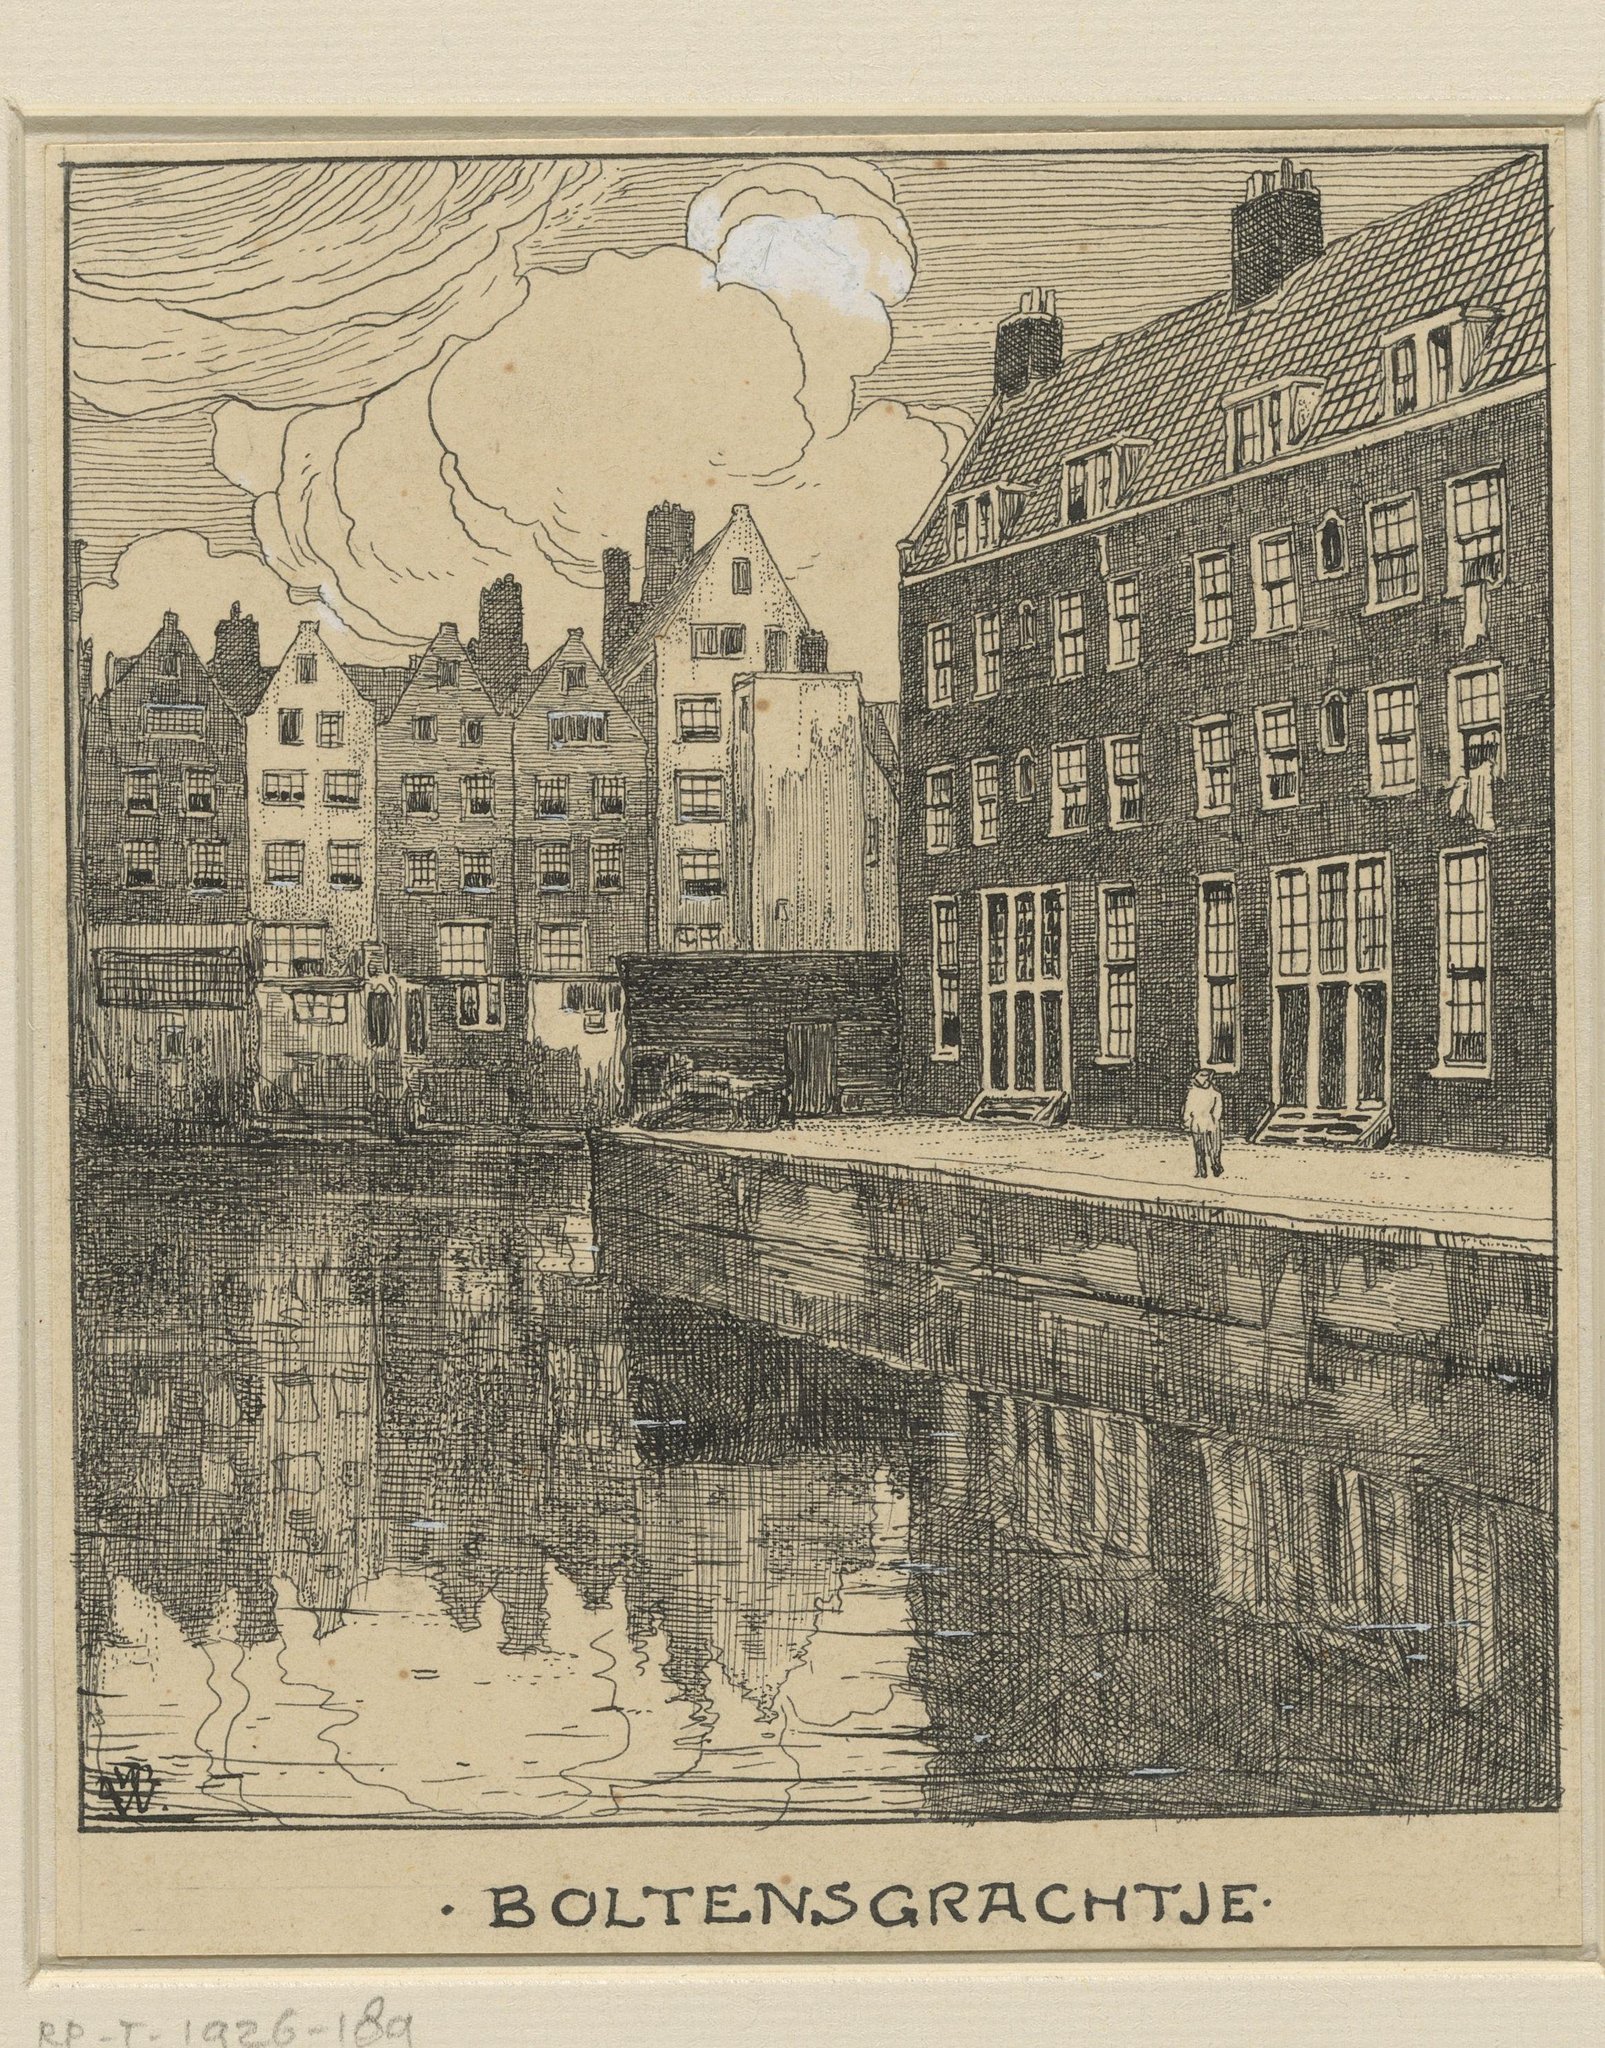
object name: drawing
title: Boltensgrachtje te Amsterdam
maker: willem wenckebach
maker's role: designer, draughtsman, painter, print maker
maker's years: 1860-1937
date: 1870-1926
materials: paint, ink, paper, pencil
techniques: pen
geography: amsterdam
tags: canals, waters (in city), amsterdam